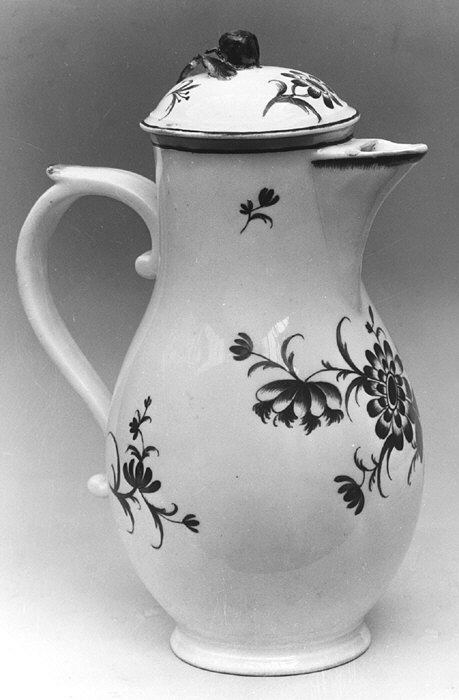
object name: coffeepot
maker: baden-baden pottery and porcelain manufactory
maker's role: manufactory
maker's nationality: german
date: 1778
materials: hard paste porcelain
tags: flowers